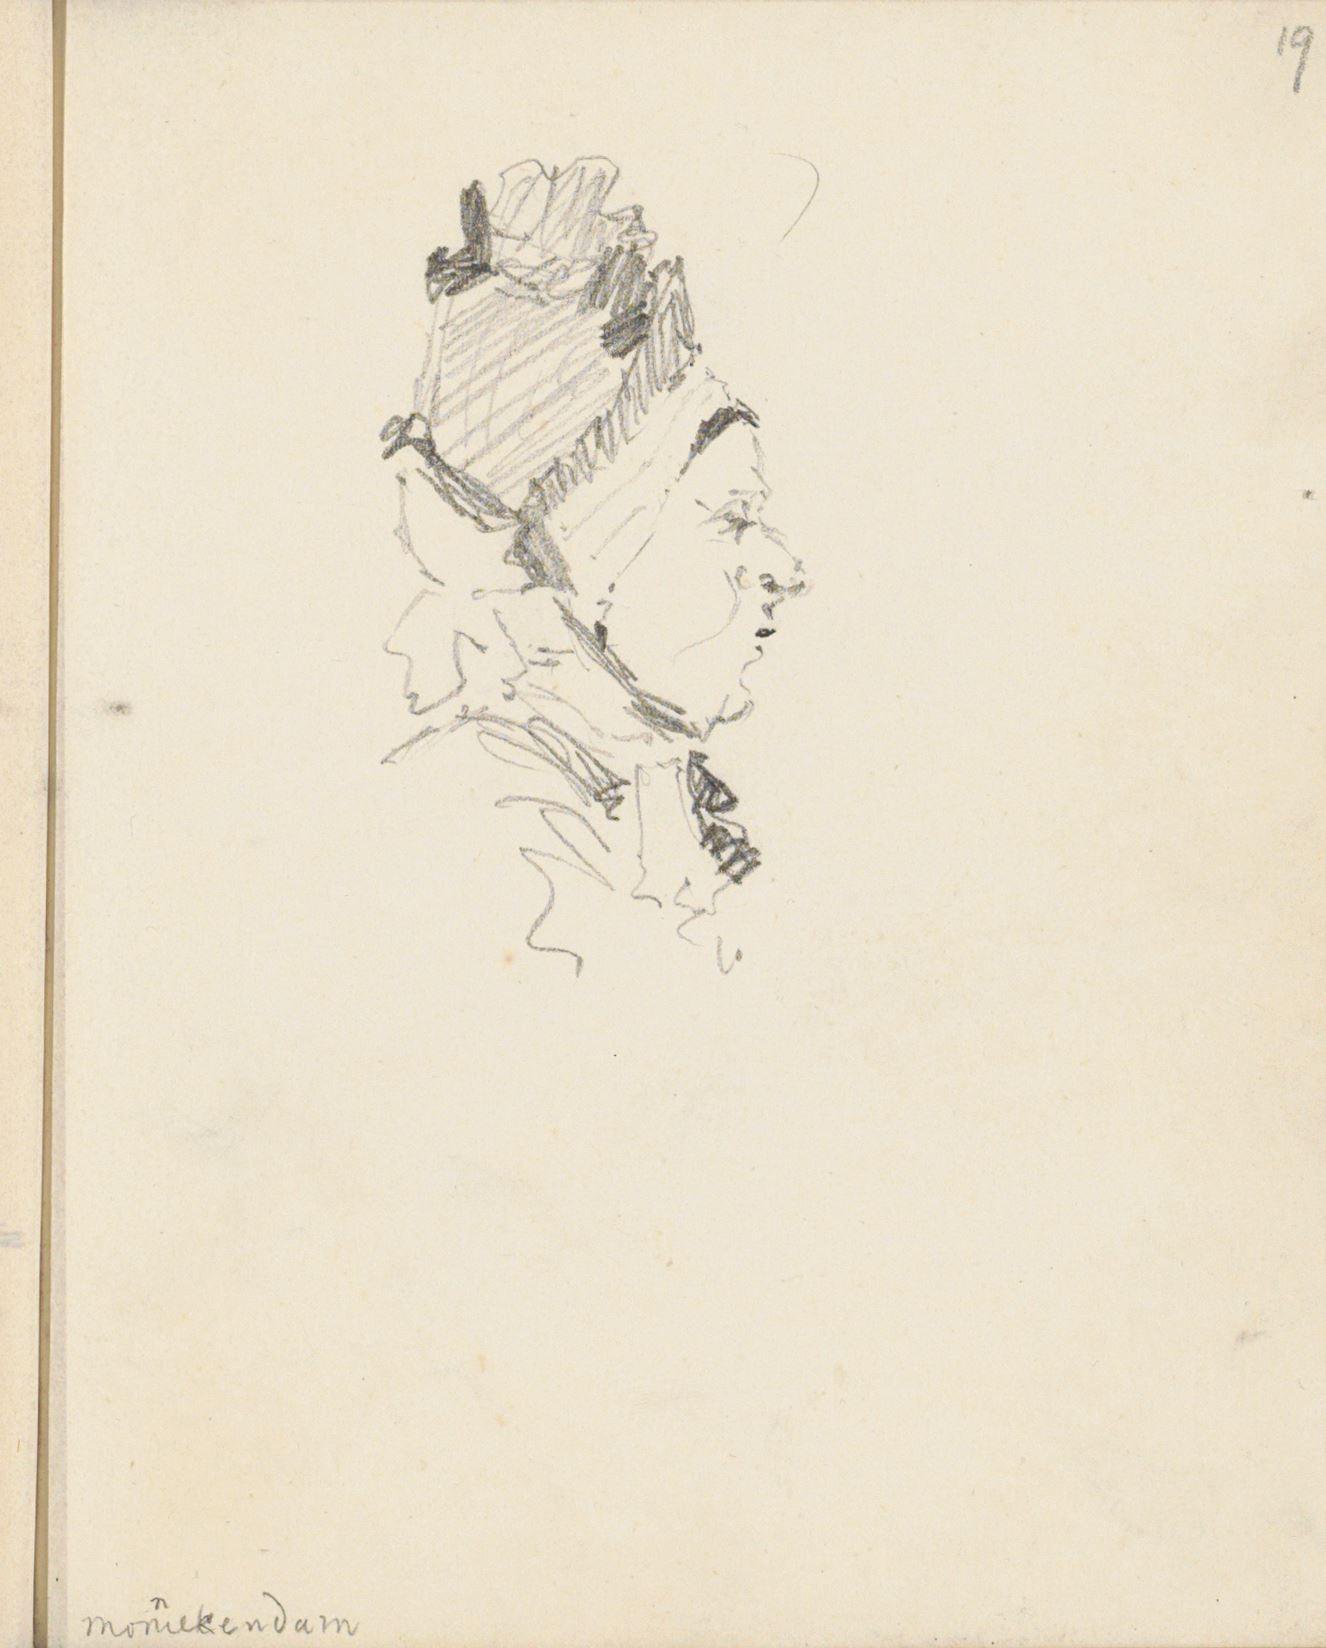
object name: sketchbook leaf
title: Hoofd van een vrouw met een Monnickendammer muts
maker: alfred william rich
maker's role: draughtsman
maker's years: 1856-1921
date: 1892-1893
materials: paper, pencil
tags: folk costume, regional costume (+ women's clothes)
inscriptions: annotation: ‘Monnickendam’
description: Blad 19 recto uit een schetsboek met 86 bladen.